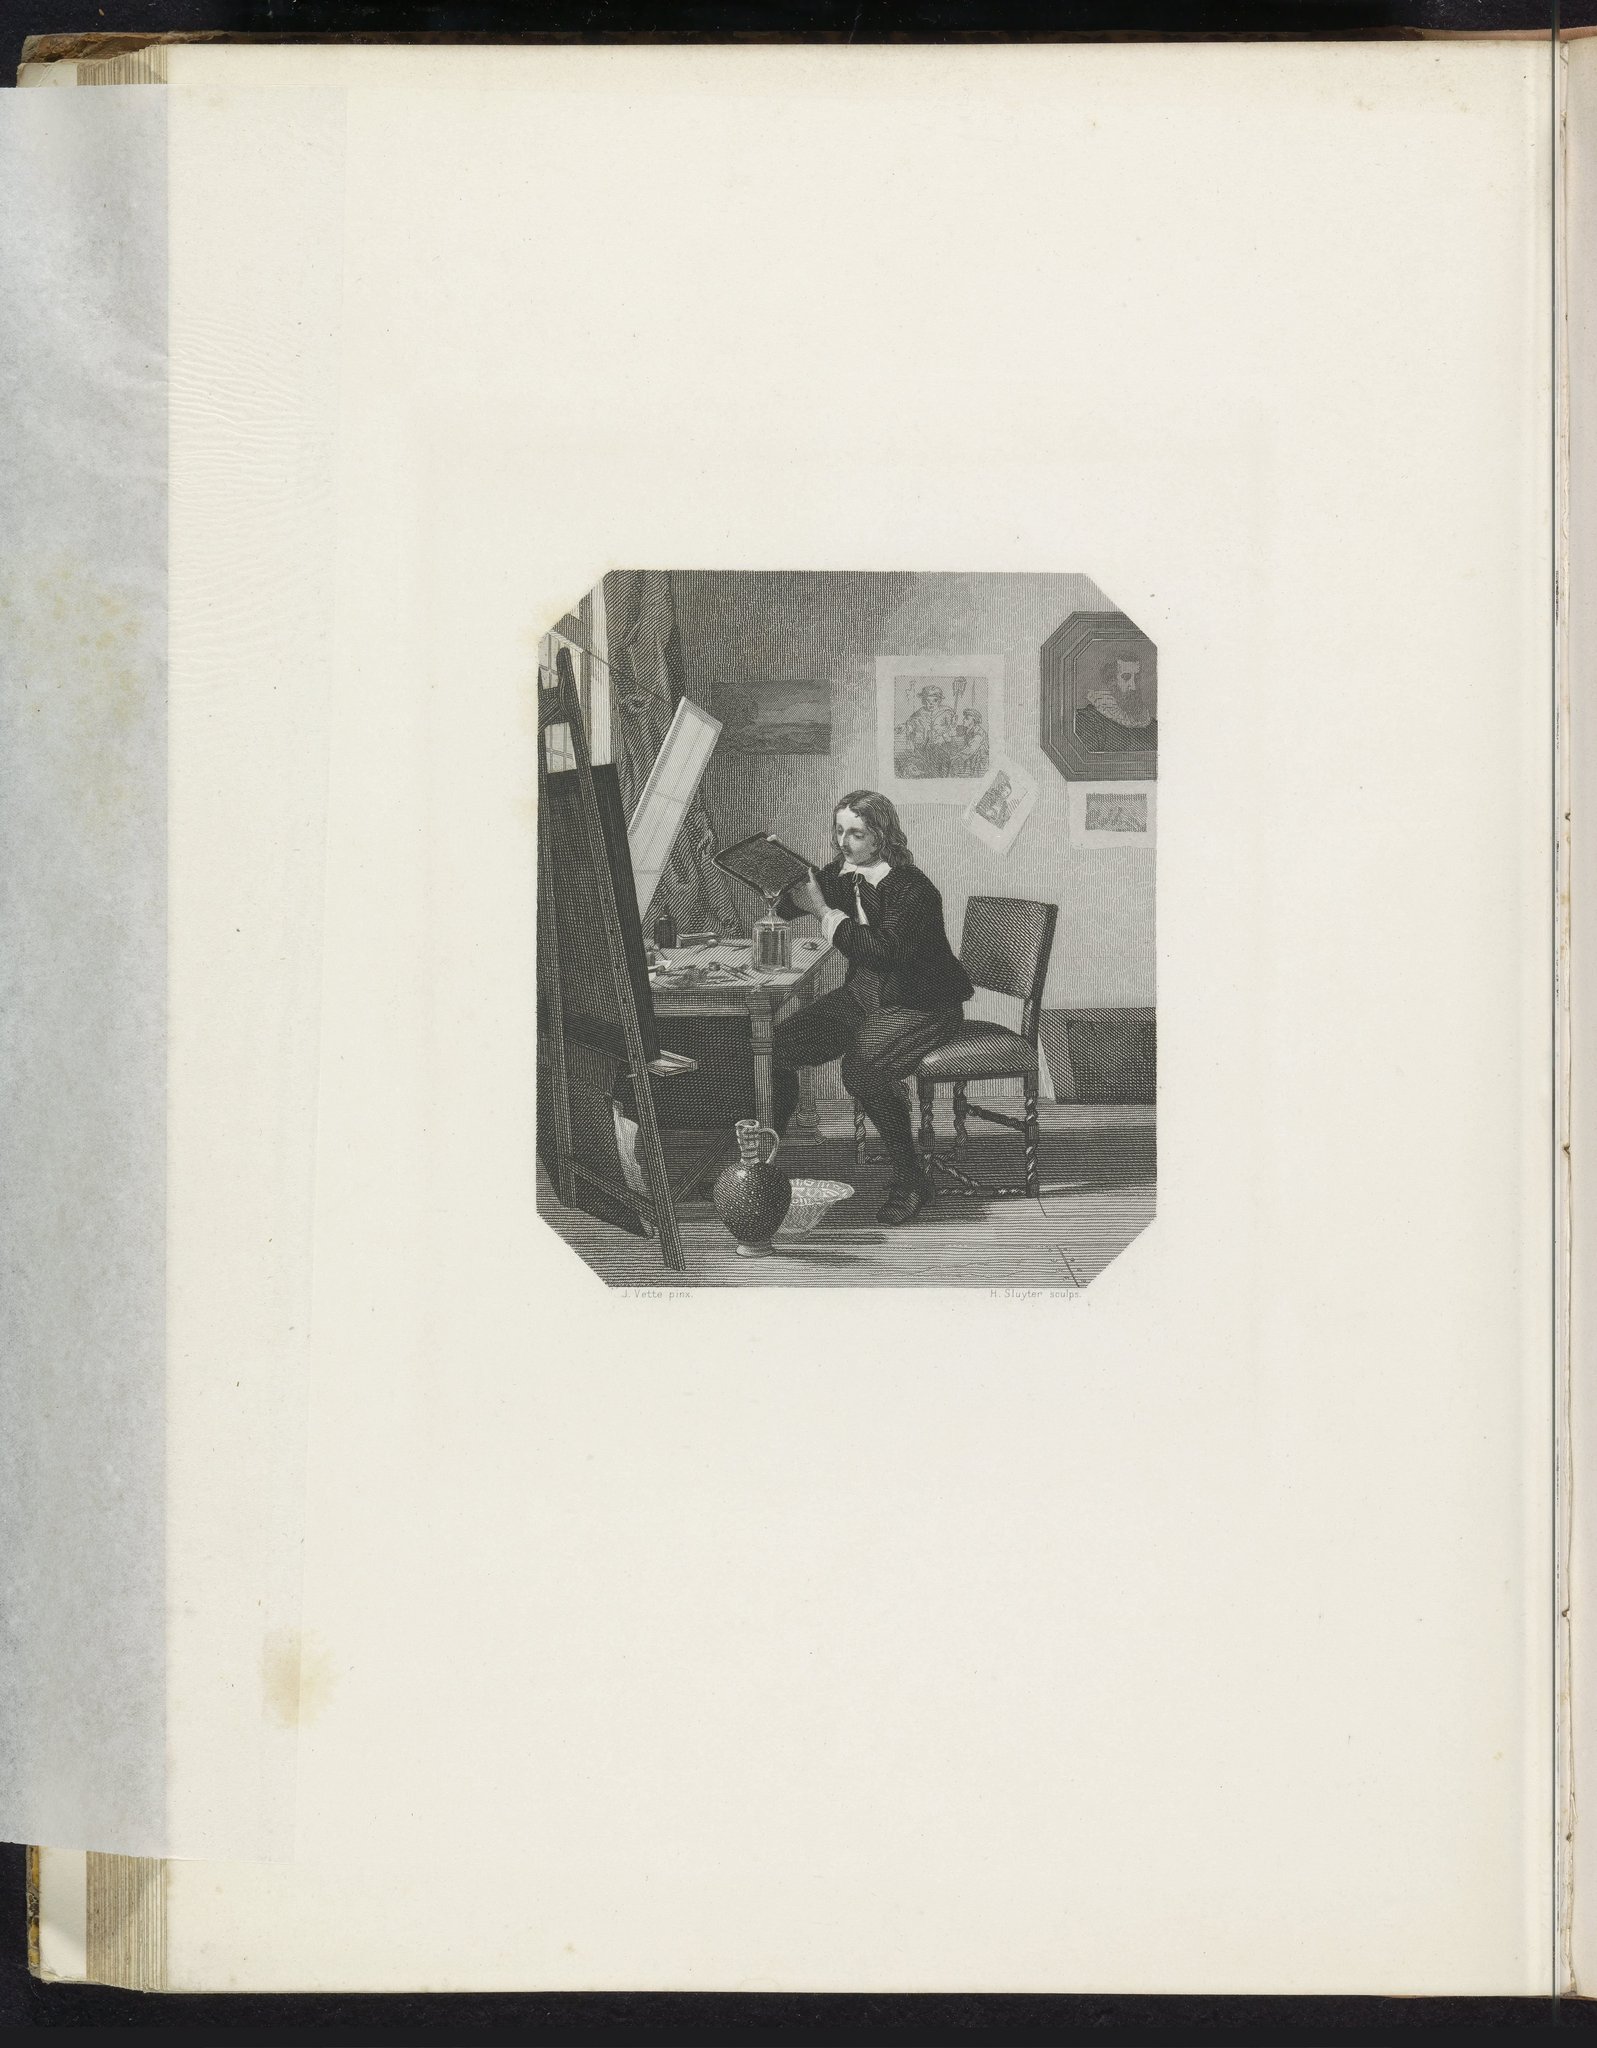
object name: history print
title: Jacob Visscher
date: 1865-1870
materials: paper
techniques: engraving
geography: netherlands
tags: painter, print maker, draughtsman, cornelis visscher (ii), engraver, etcher (+ in workshop or studio)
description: De etser Cornelis Visscher (II) giet in zijn werkplaats het zuur van een etsplaat, ca. 1648. Onderdeel van de groep staalgravures naar de schilderijen van de Historische Galerij der Maatschappij Arti et Amicitiae.